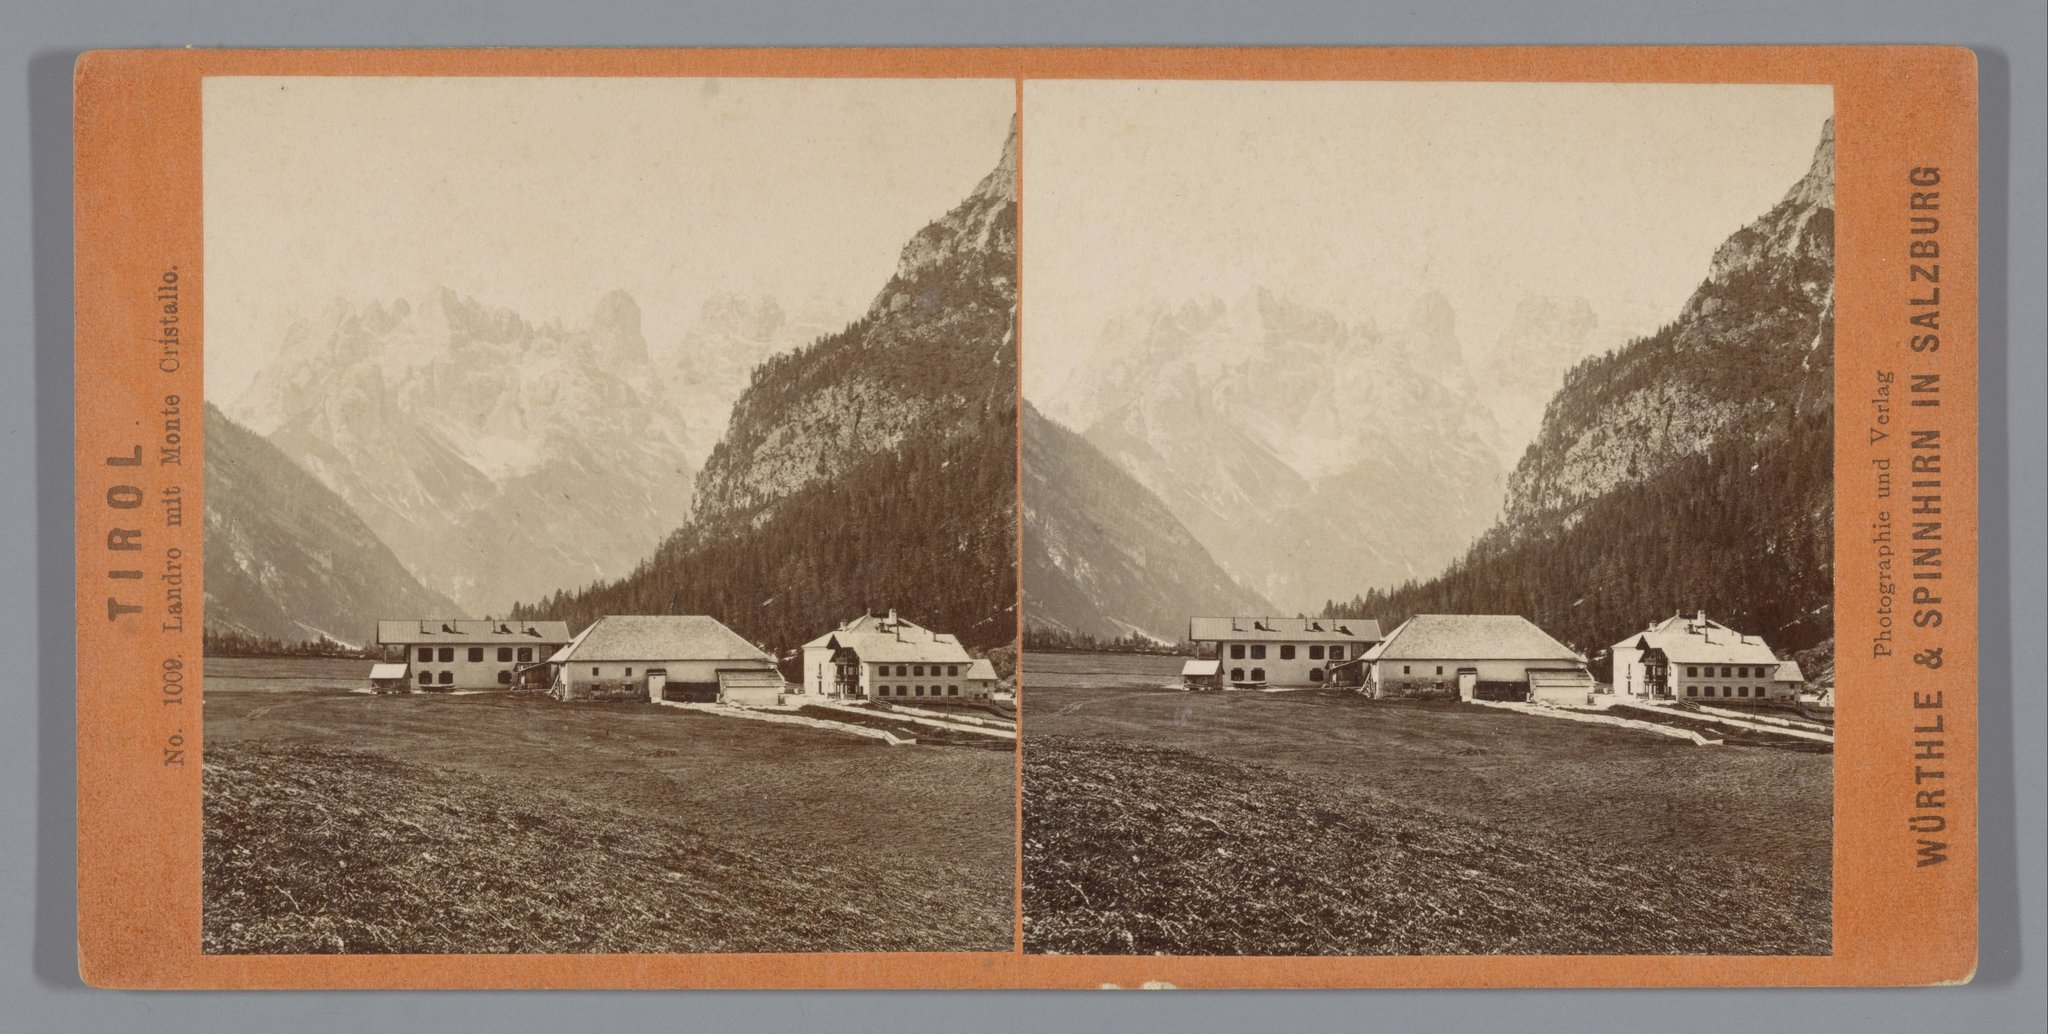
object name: stereograph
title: Gezicht op de Monte Cristallo te Veneto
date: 1850-1900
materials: cardboard, photographic support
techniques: albumen print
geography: veneto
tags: mountain-range, snow peaks, façade (of house or building)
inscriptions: number: ‘No. 1009.’